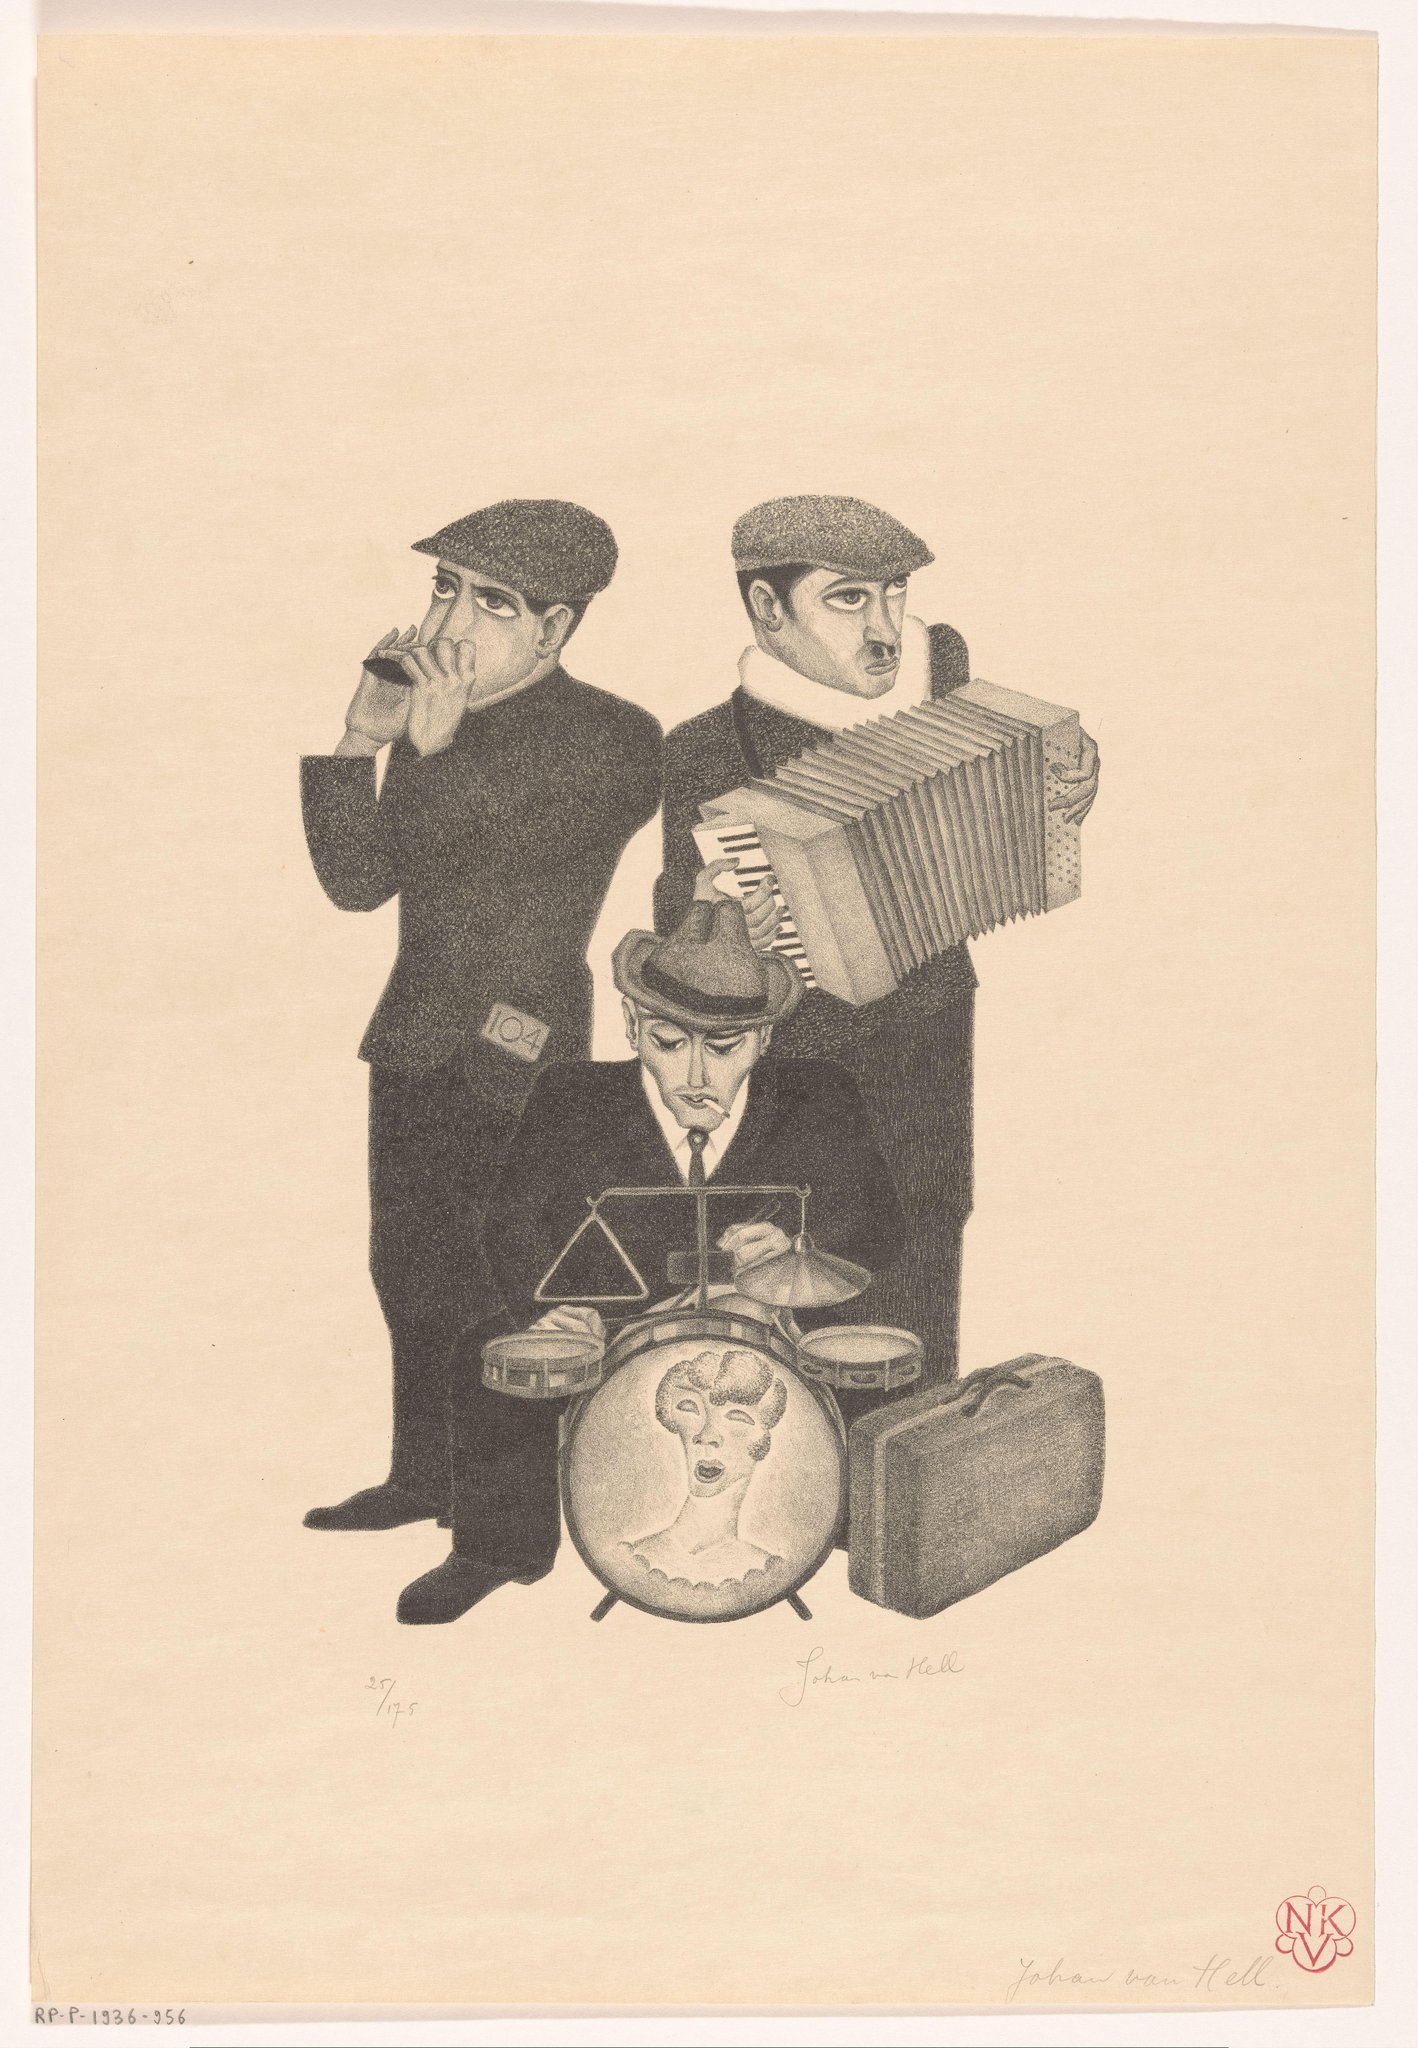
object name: print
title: Straatmuzikanten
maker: johan van hell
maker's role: print maker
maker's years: 1889-1952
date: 1925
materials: paper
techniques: lithograph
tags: musician - cc - out of doors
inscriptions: collector's mark: Lugt 2228, stamp: ‘NKV’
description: Een ocarinaspeler, een accordeonist en een drummer op straat. De drummer rookt een sigaret. Op zijn drumstel de beeltenis van een vrouw.